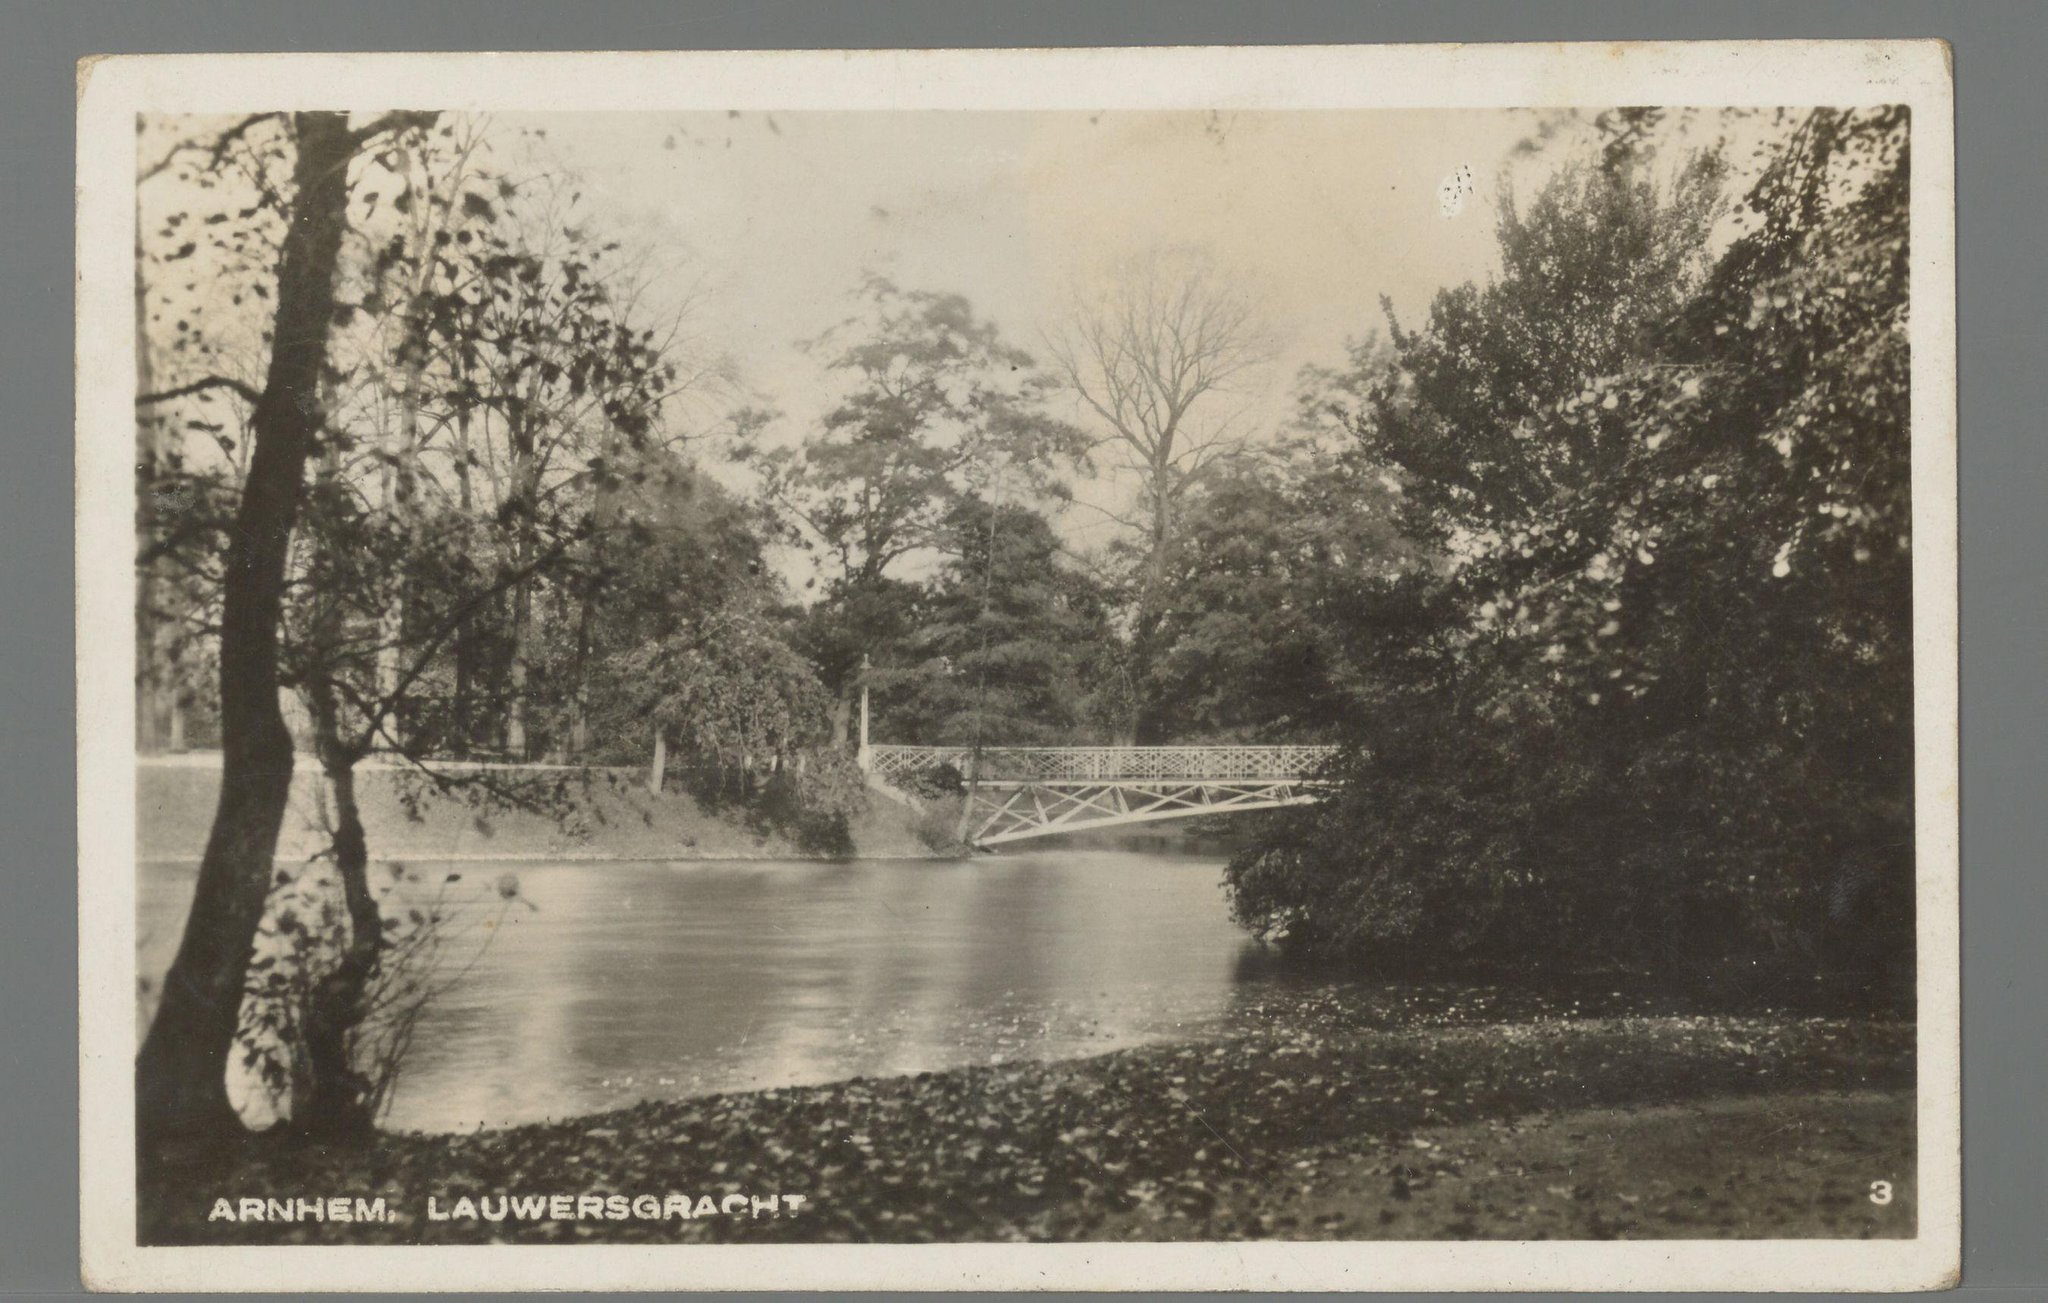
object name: photograph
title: Arnhem, Lauwersgracht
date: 1929-1931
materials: photographic support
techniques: photography, writing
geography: arnhem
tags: landscape with bridge, viaduct or aqueduct, arnhem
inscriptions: poststempel, verso, gestempeld